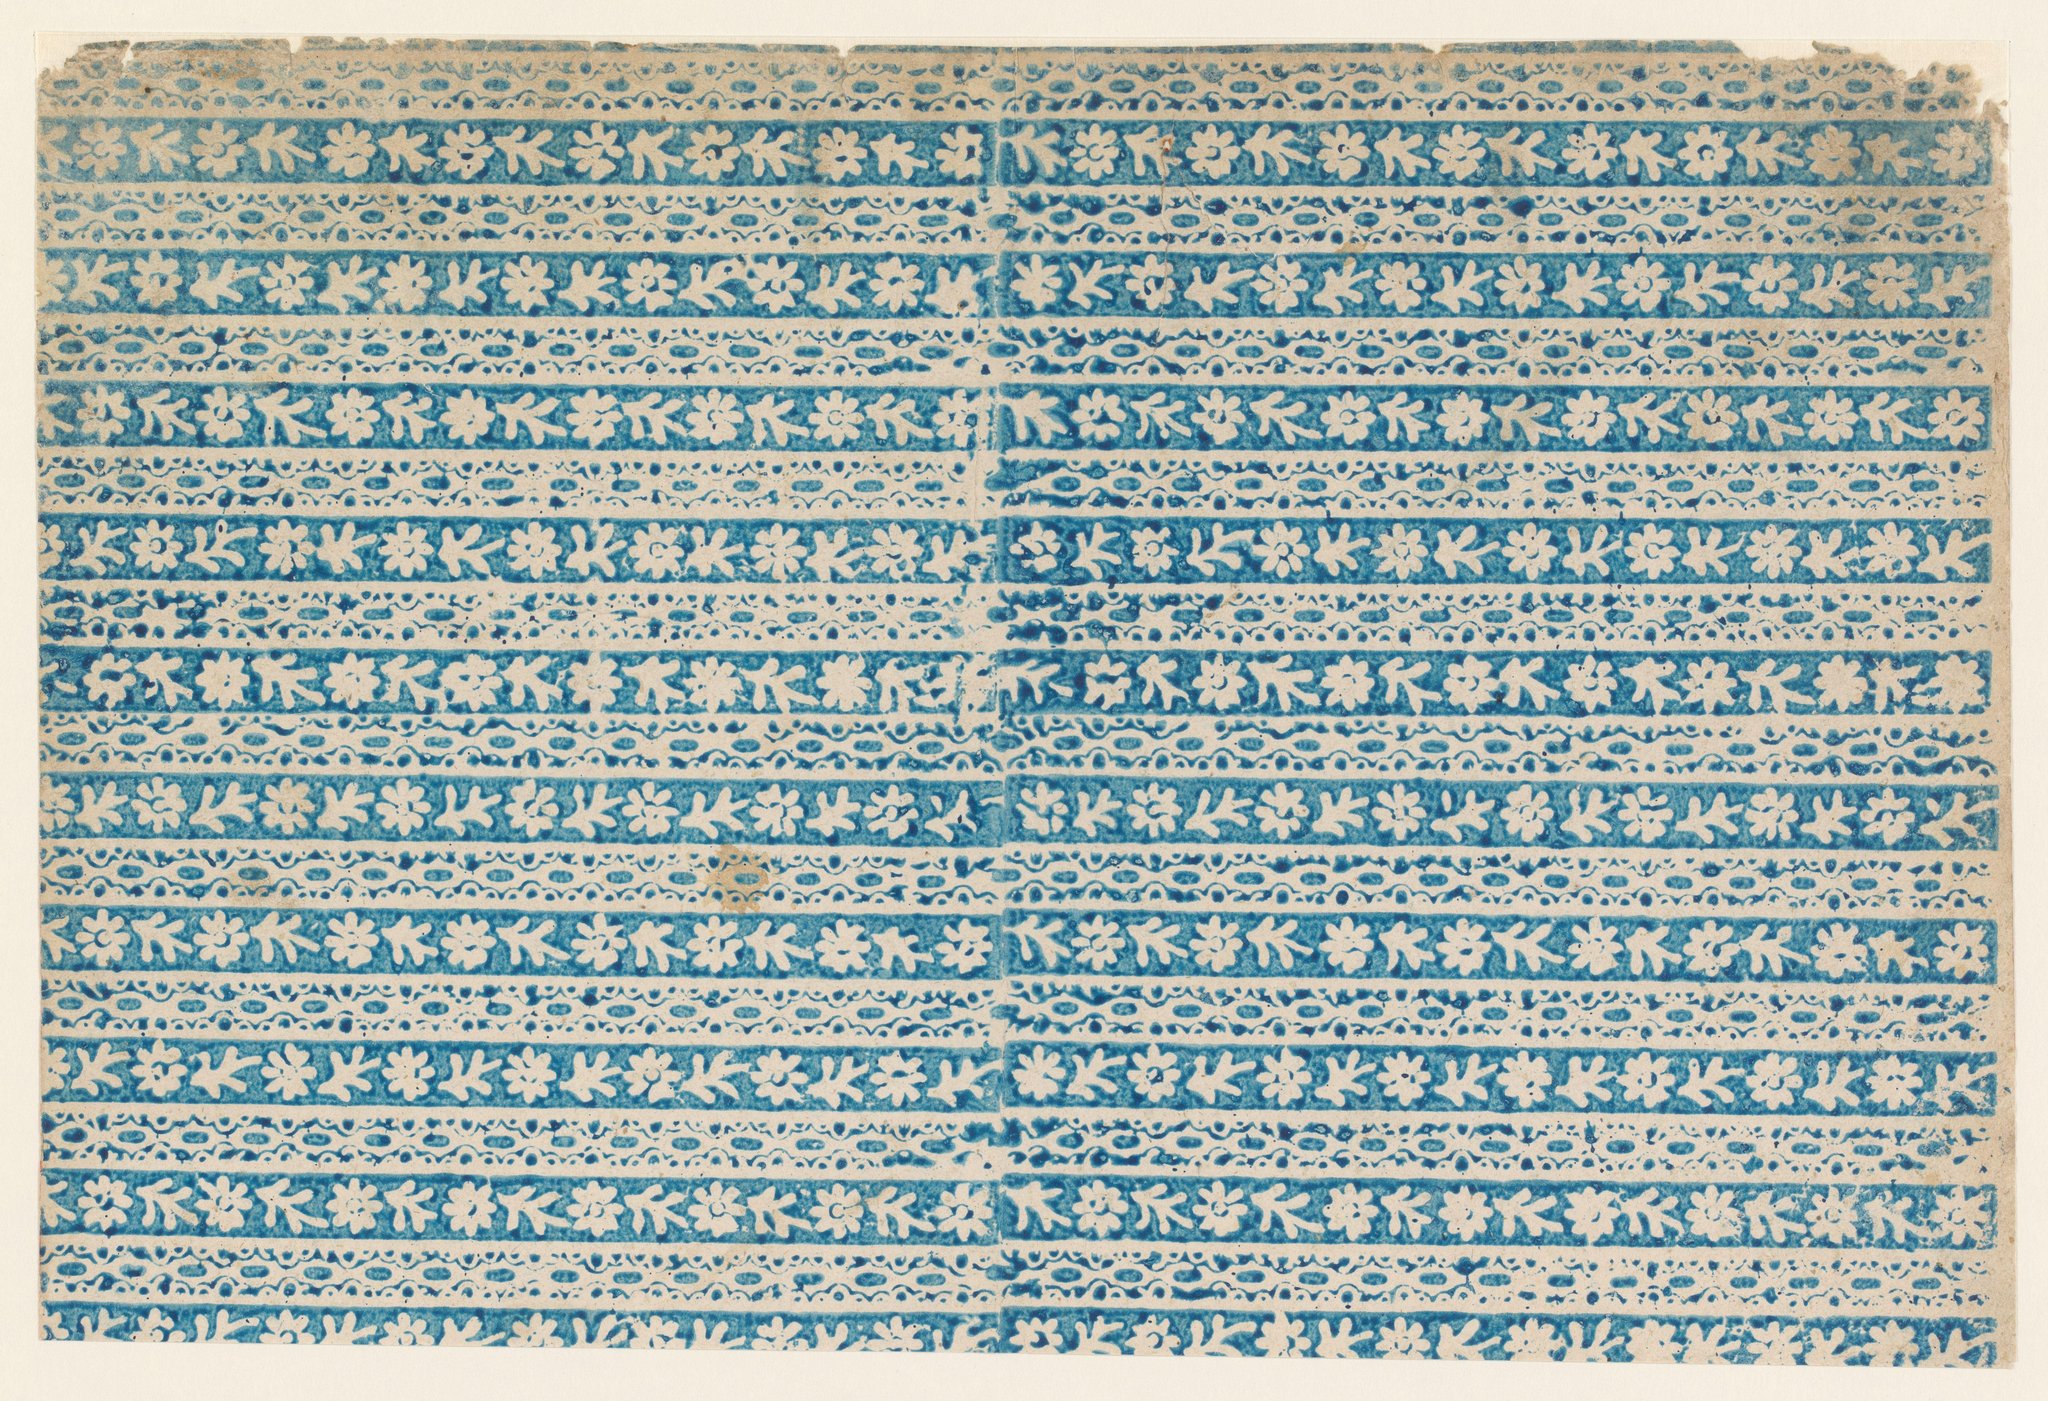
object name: printed paper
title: Blad met banenpatroon van uitgespaarde bloemen en sierlijst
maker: Anonymous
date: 1700-1850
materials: paper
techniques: printing block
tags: ornament derived from plant forms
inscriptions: collector's mark: Lugt 2228, collector's mark: Lugt 2760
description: Blad met banenpatroon van uitgespaarde bloemen en sierlijst. Mogelijk gebruikt als omslag.